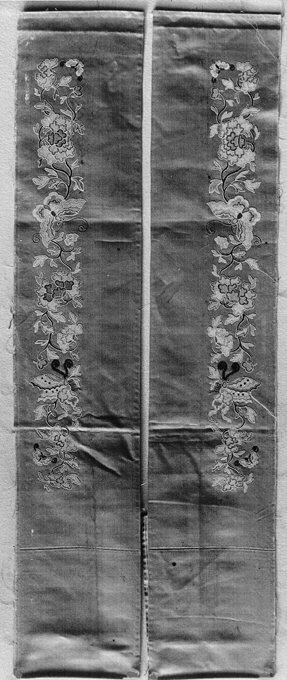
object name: sleeve band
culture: chinese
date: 1801-1900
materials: metal thread, silk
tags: flowers